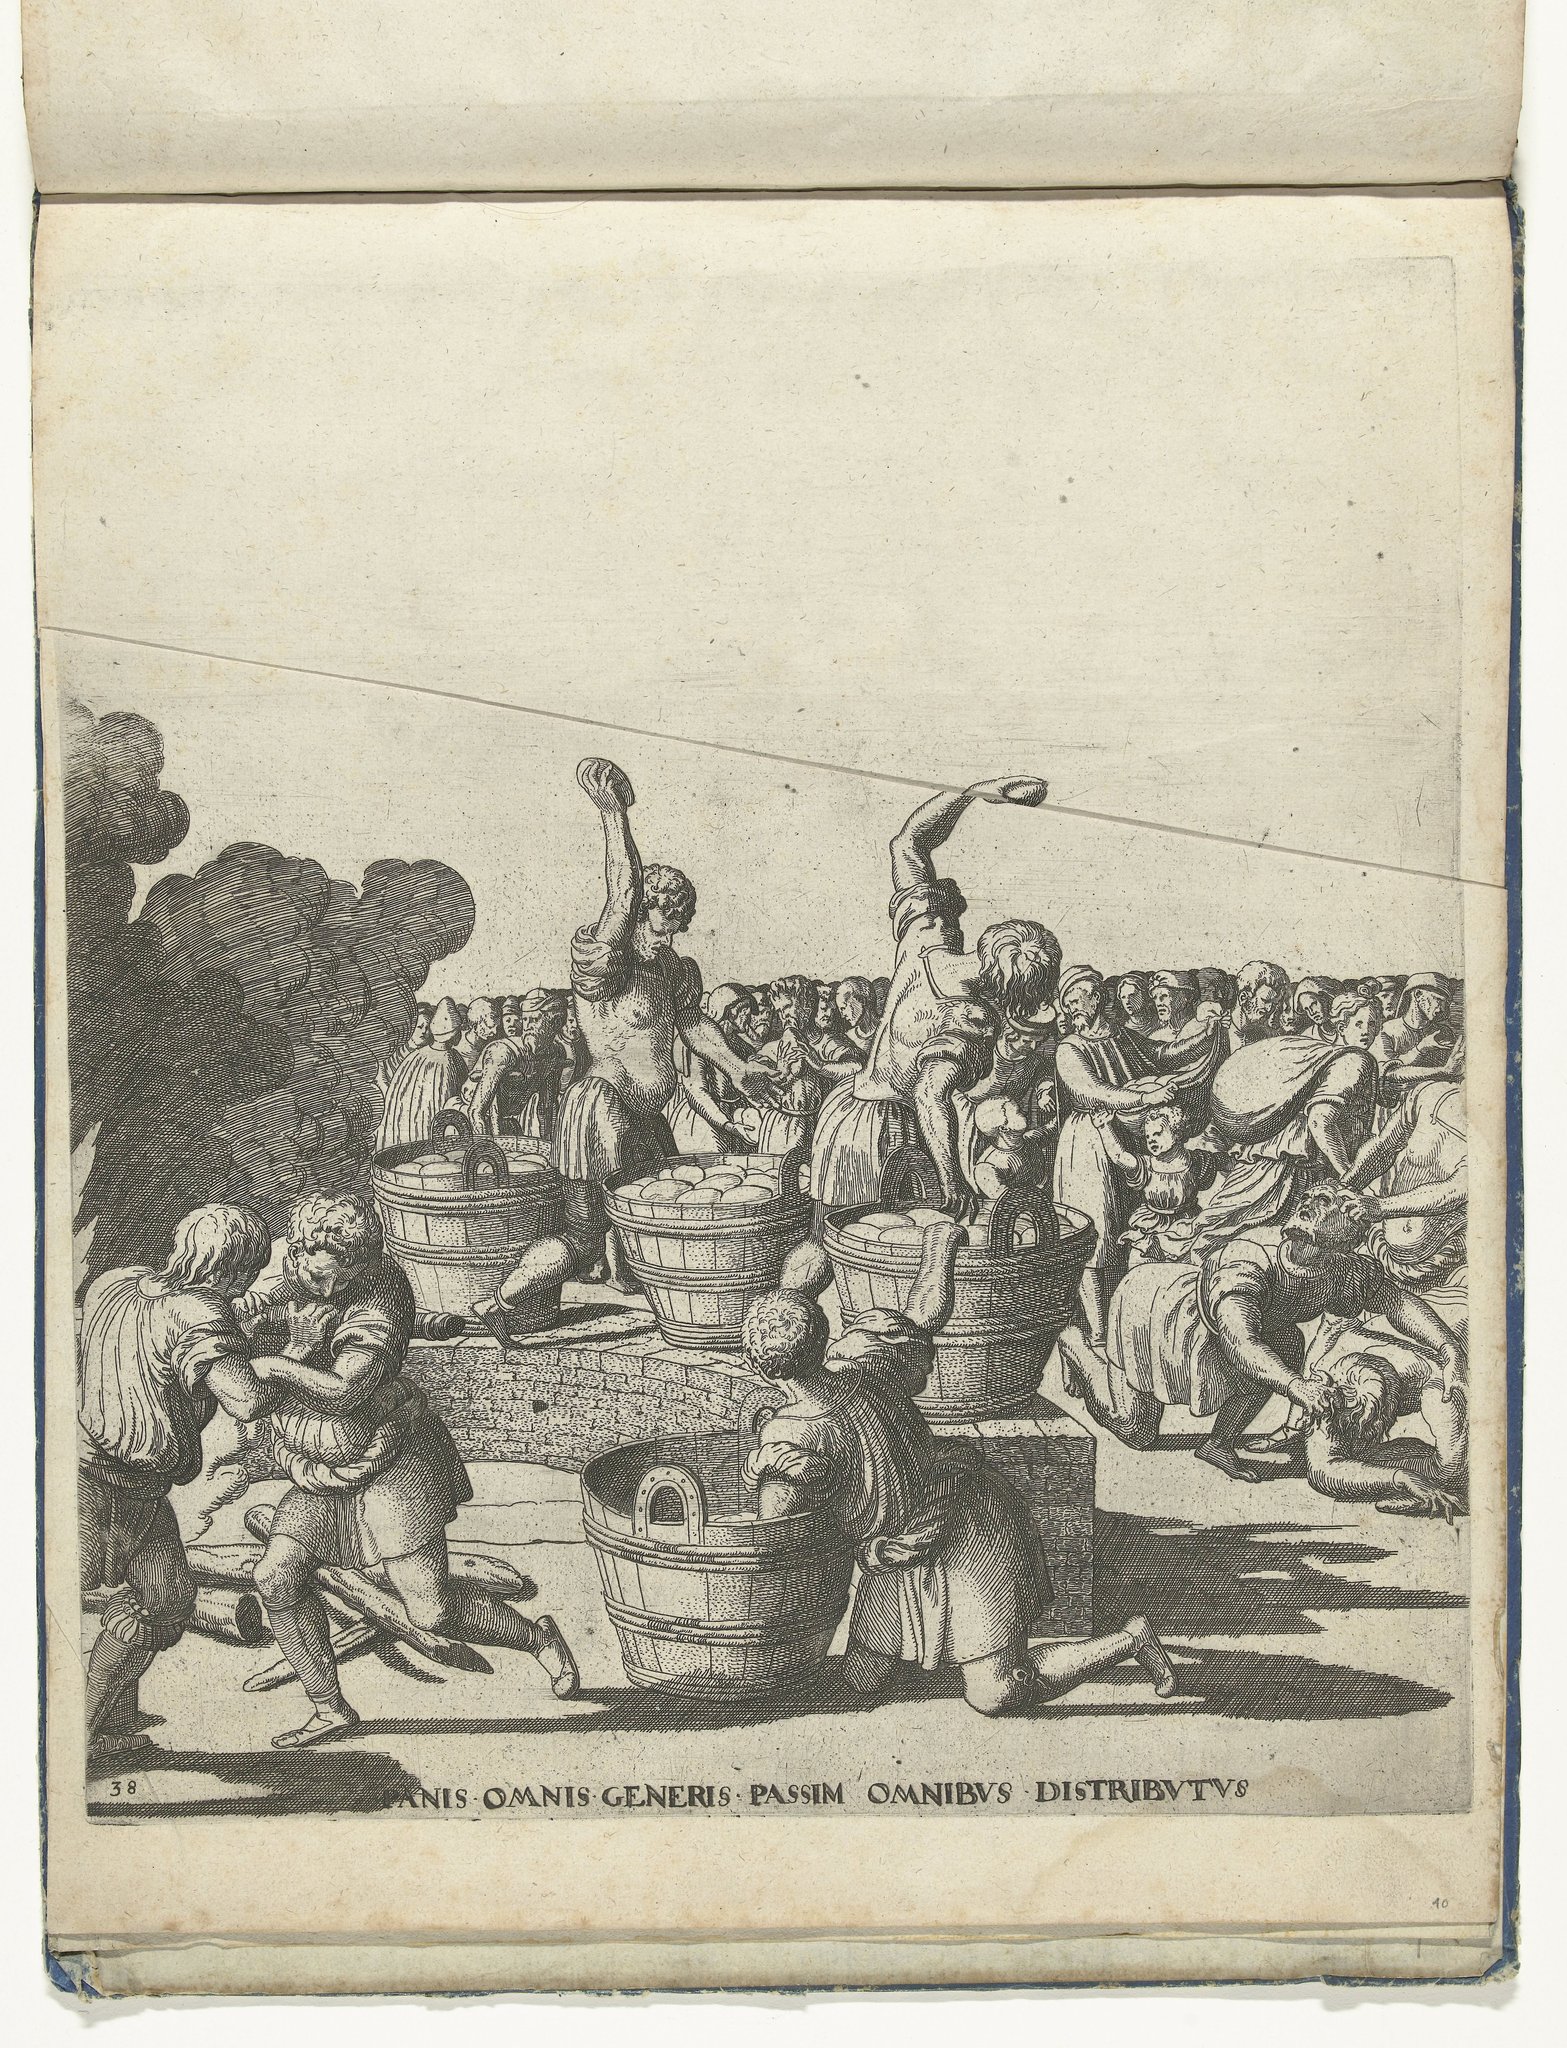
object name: album leaf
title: Optocht van Karel V met de paus te Bologna na zijn kroning to keizer, 1530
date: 1530-1536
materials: paper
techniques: engraving, etching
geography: the hague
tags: ghent, charles v (holy roman emperor and king of spain), festivities (+ parade, pageant, cavalcade ~ festive activities)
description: Prent in het album waarin zijn ingeplakt de 40 platen die achterelkaar samen het fries vormen van de optocht van Karel V met de paus Clemens VII te Bologna na zijn kroning tot keizer, 24 februari 1530.